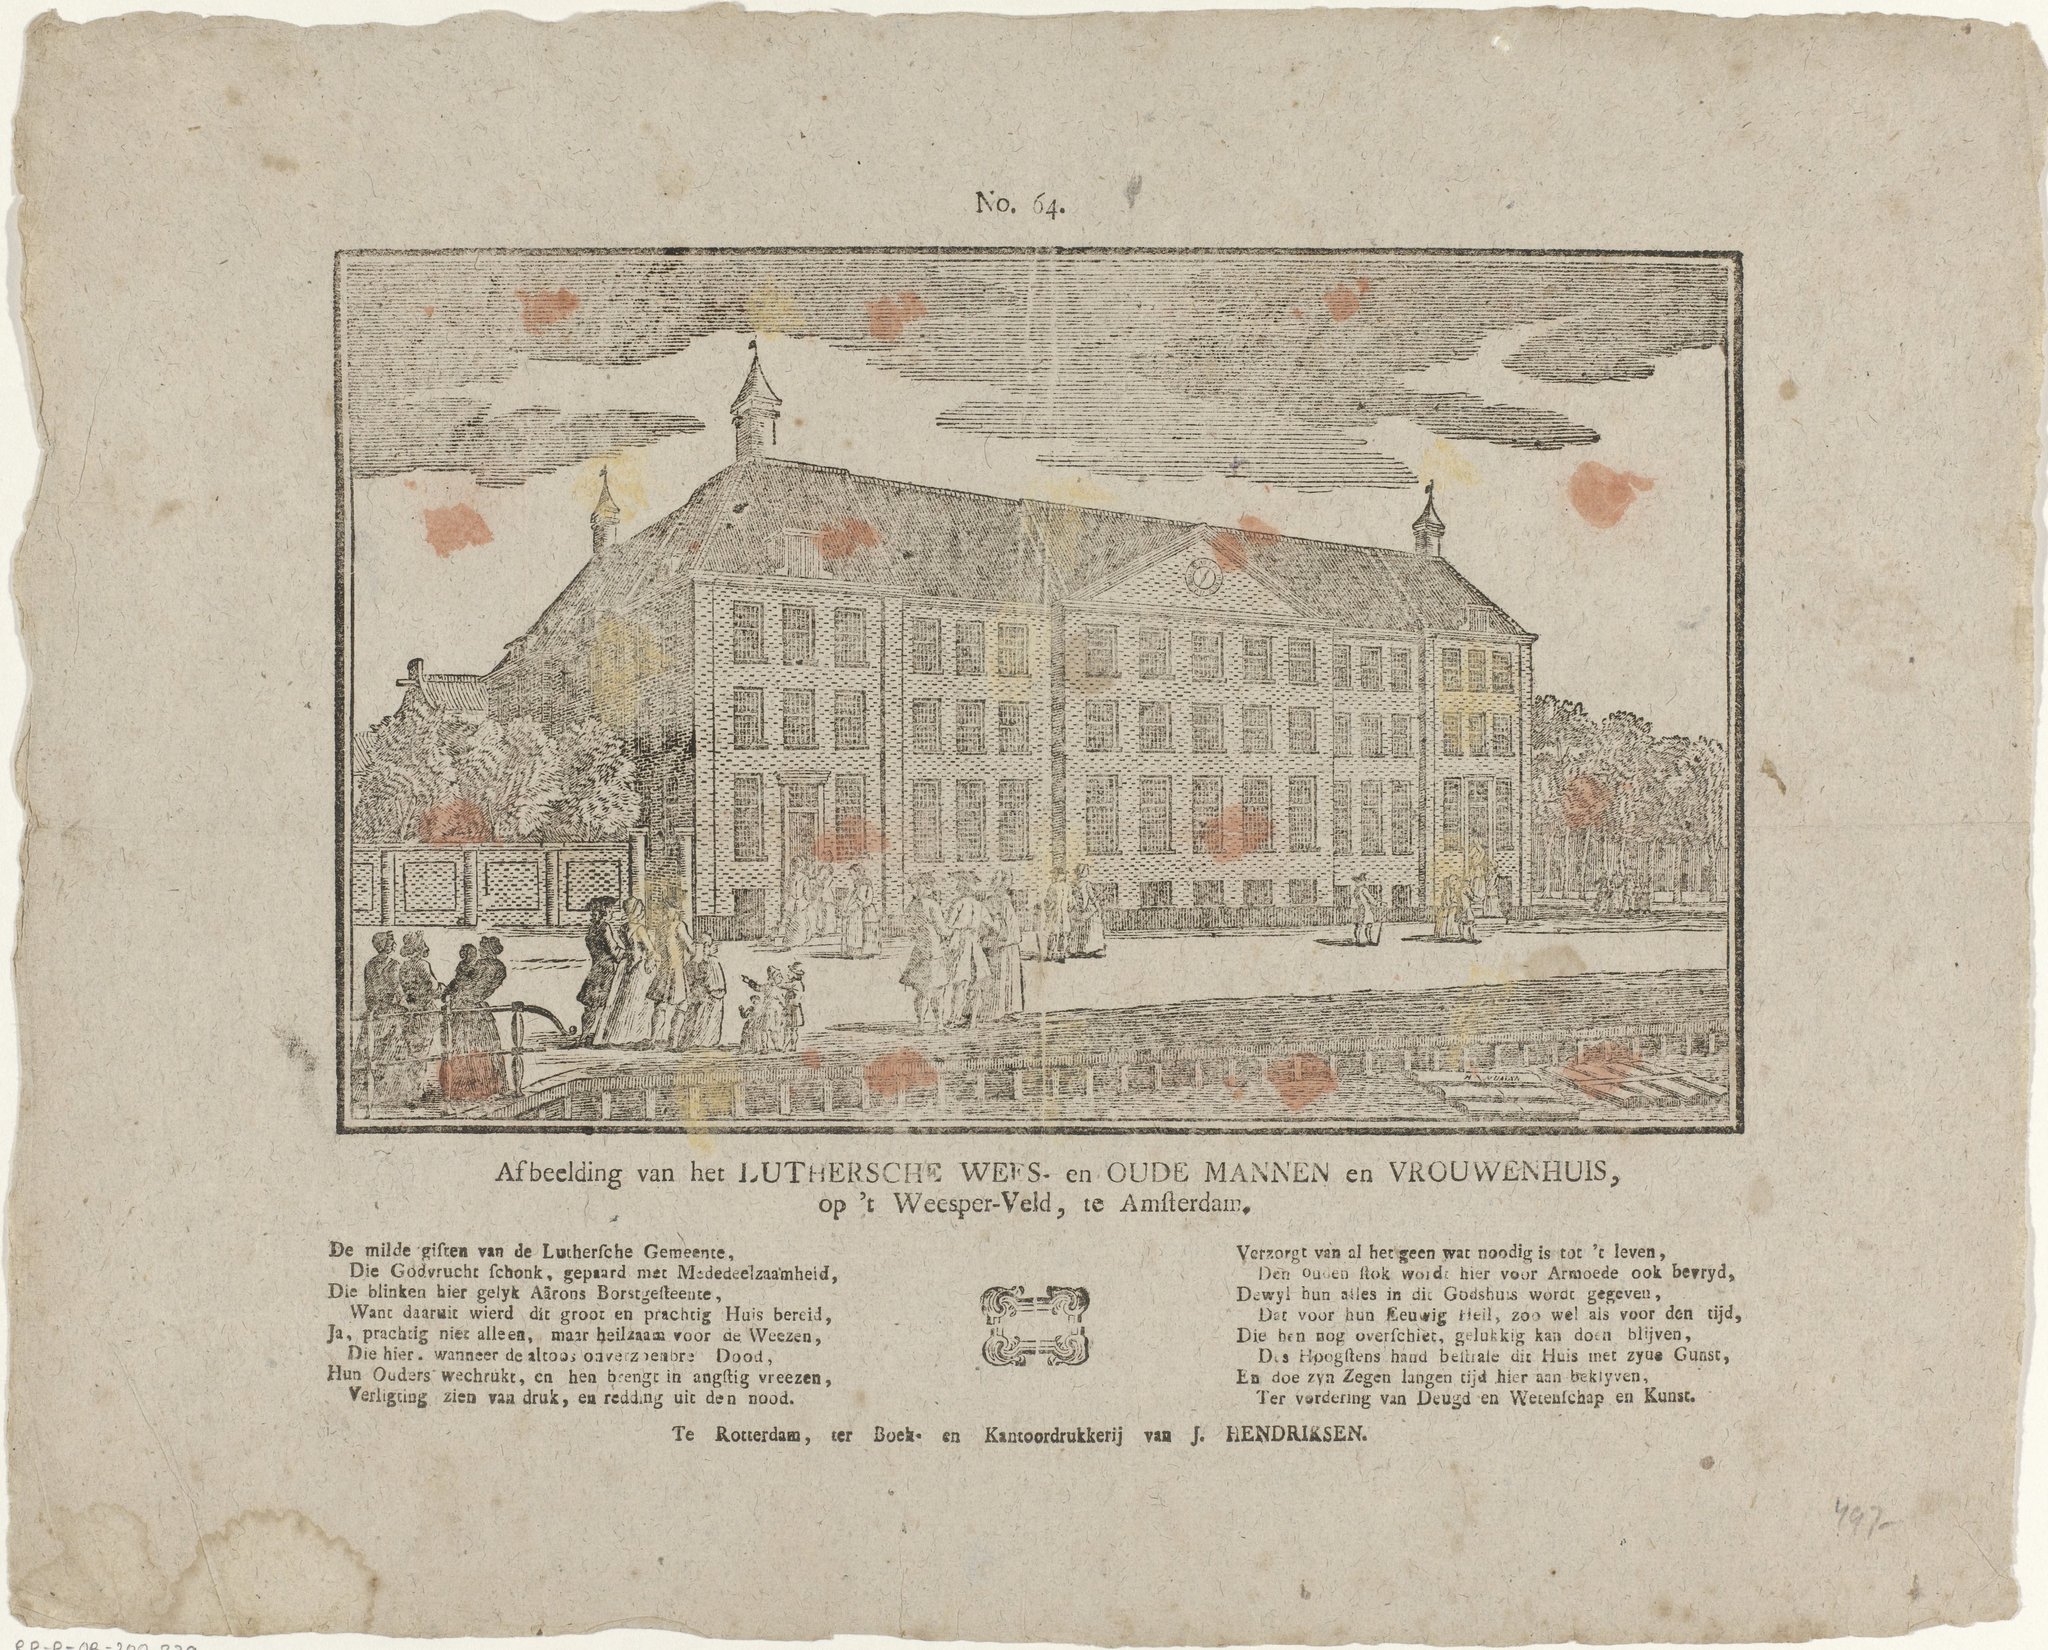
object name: popular print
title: Gezicht op het Lutherse Diaconiehuis te Amsterdam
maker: jan hendriksen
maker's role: bookseller, printer, publisher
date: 1781-1828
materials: paper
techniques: colour, letterpress printing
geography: rotterdam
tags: orphanage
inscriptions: collector's mark: Lugt 2228, collector's mark: Lugt 2760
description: Blad met grote voorstelling van het Lutherse Diaconiehuis op 't Weesperveld te Amsterdam. In de ondermarge een zestienregelig vers in twee kolommen. Genummerd midden boven: No. 64.